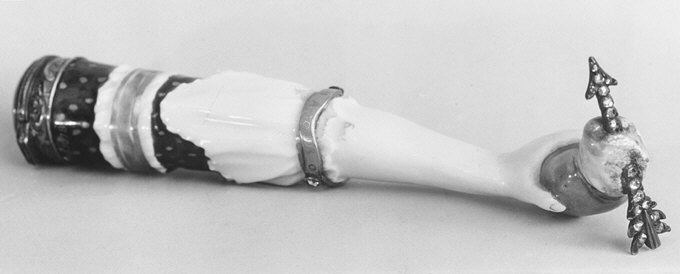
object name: needle case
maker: meissen manufactory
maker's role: manufactory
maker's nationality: german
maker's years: 1710-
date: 1701-1800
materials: gold, porcelain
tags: arrows,hands